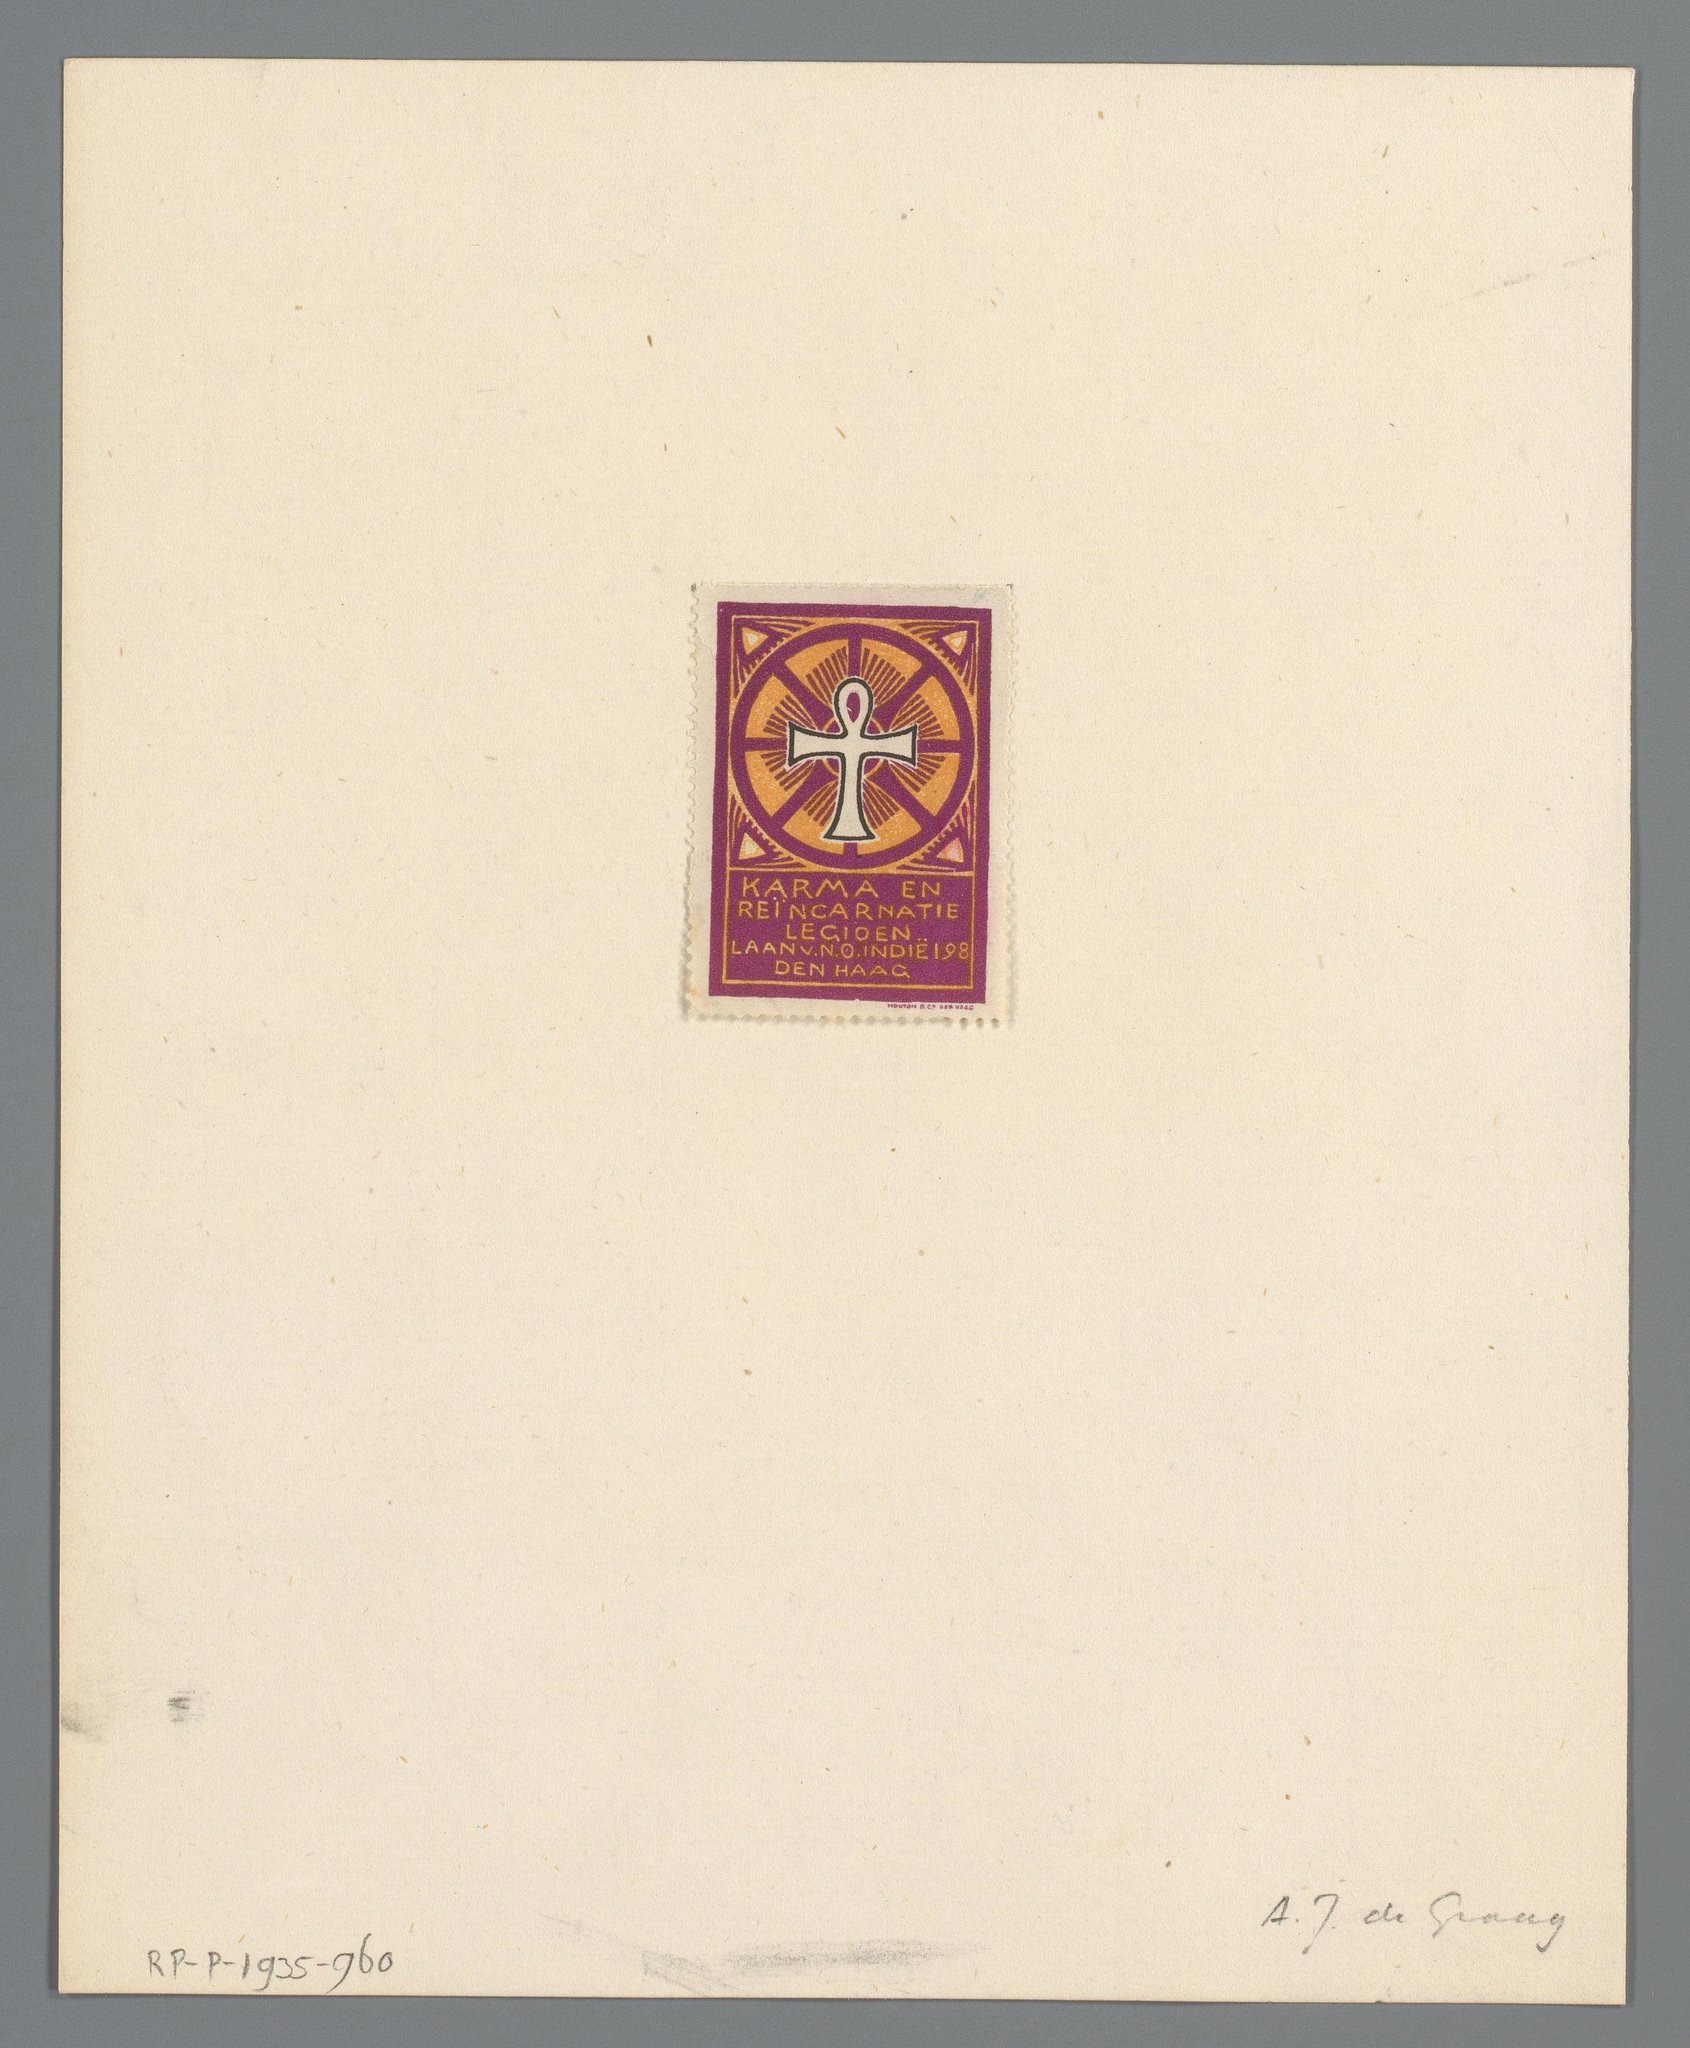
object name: print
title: Sluitzegel van het Karma en Reïncarnatielegioen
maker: julie de graag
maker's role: draughtsman, print maker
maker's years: 1877-1924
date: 1910-1930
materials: gum, paper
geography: the hague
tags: specific forms of the cross: ansate cross, the hague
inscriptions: collector's mark: Lugt 2228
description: Sluitzegel van het Karma en Reïncarnatielegioen, Den Haag. Symbool met stralende anck of ankh-teken in een cirkel.